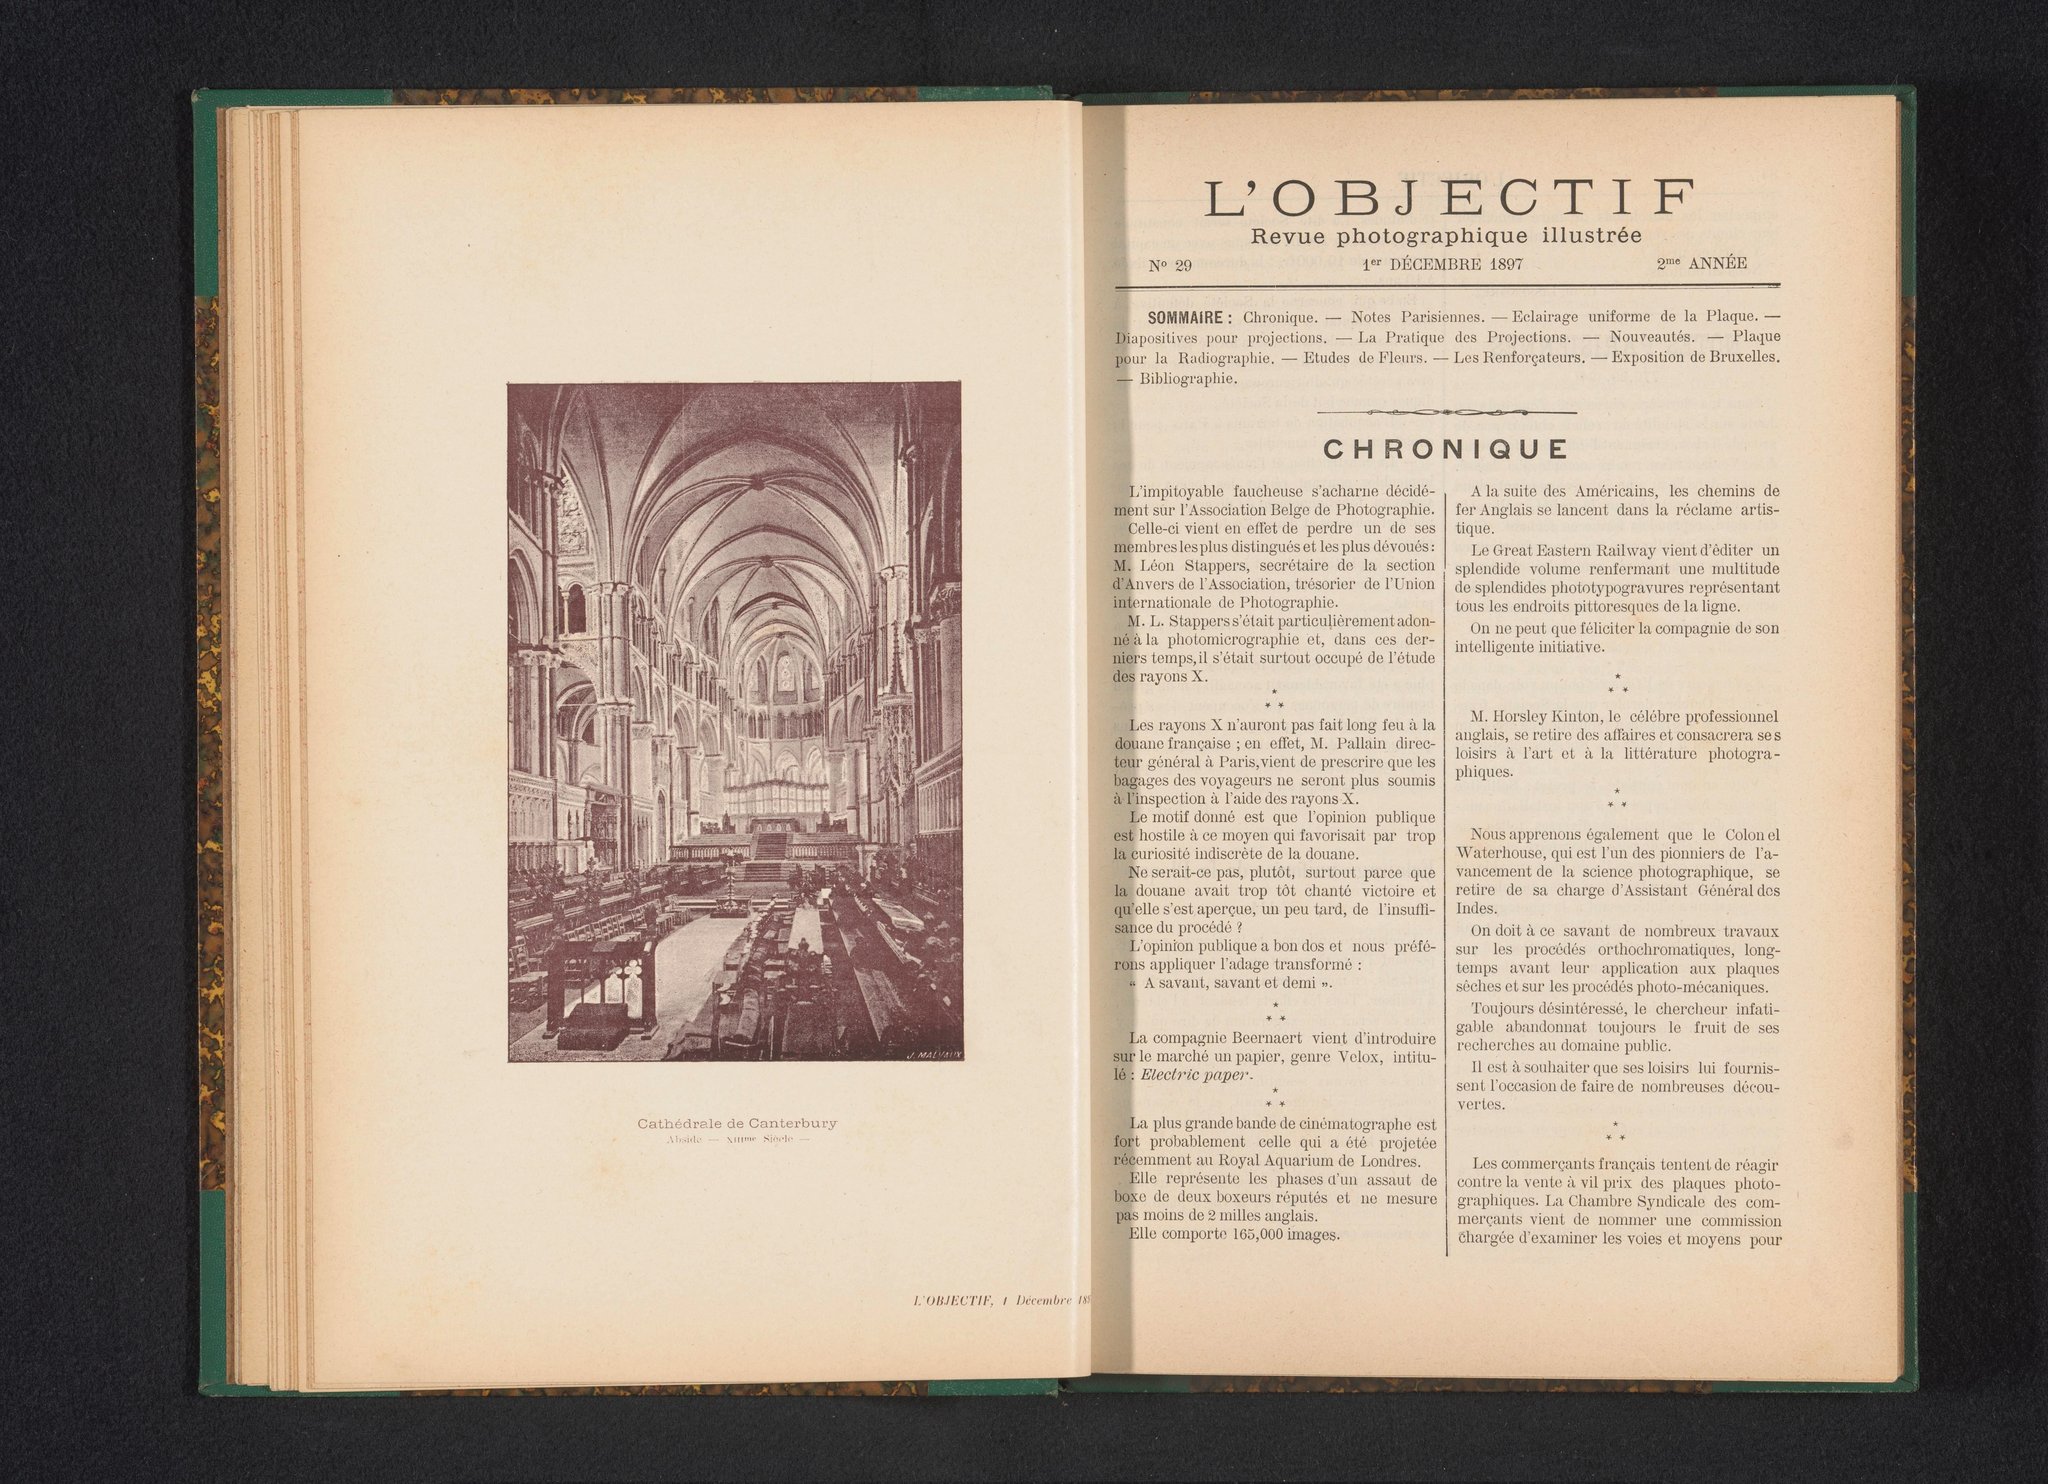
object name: page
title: Interieur van de kathedraal van Canterbury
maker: jean malvaux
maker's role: printer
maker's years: 1839-1903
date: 1896-1900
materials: paper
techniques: autotype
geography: canterbury cathedral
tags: interior of church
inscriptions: inscription: ‘Abside - XIIme Siècle’, inscription: ‘L'objectief, 1 Décembre 1897’